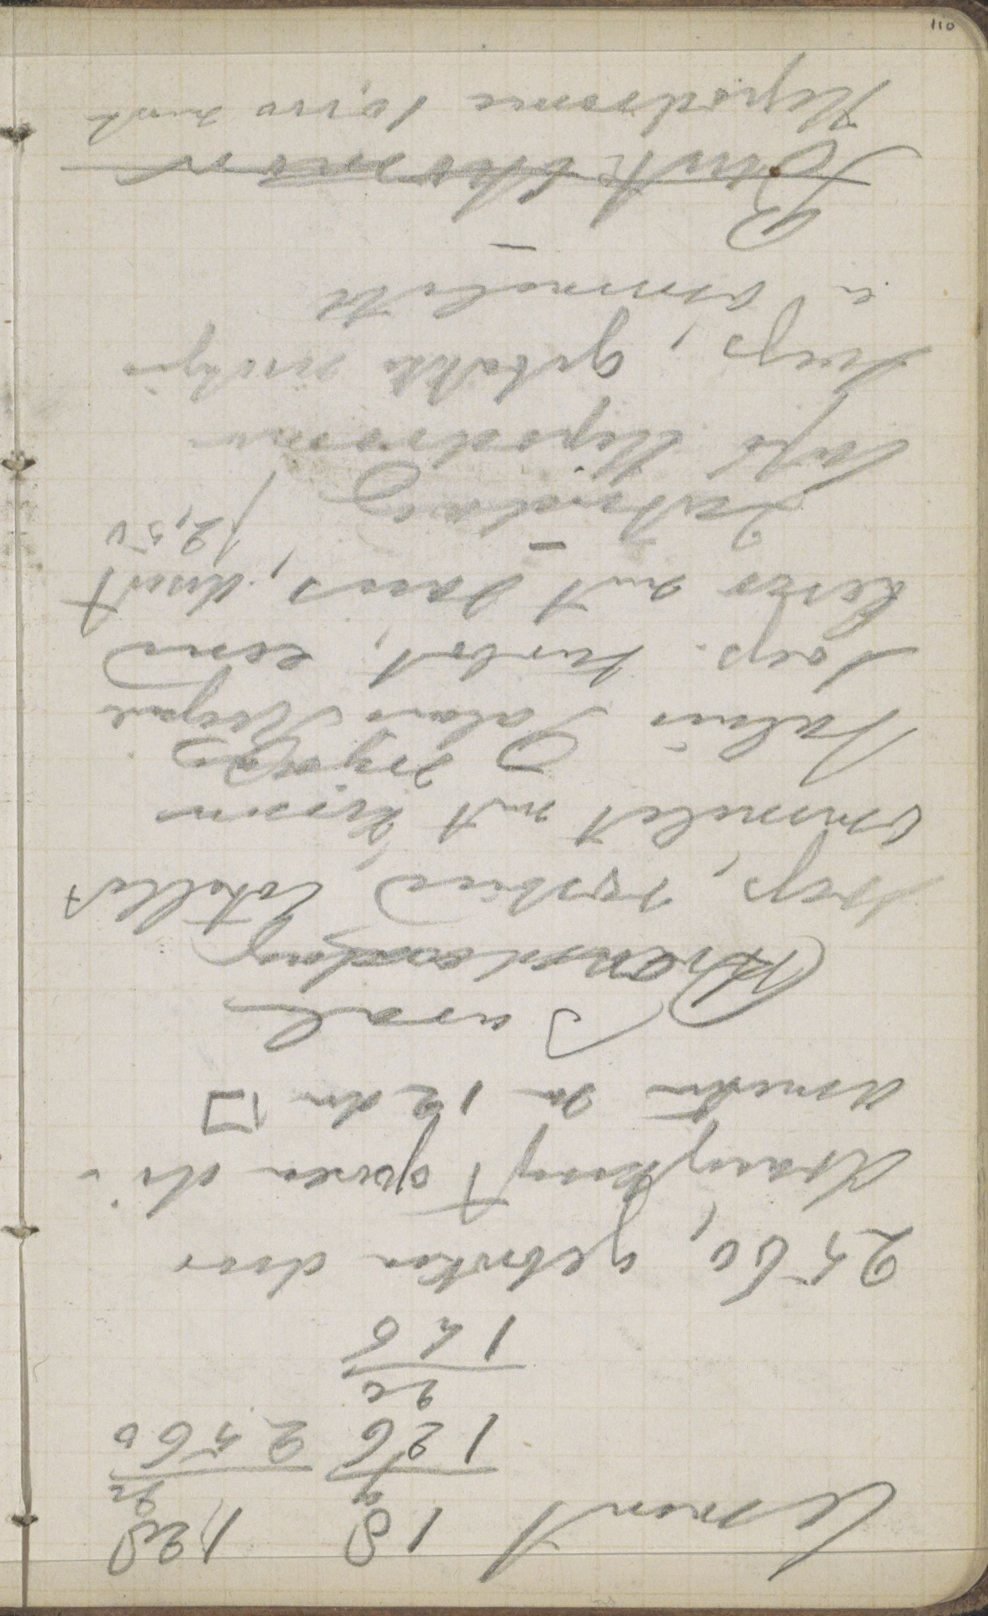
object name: sketchbook leaf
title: Blad met notities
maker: marius bauer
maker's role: draughtsman, print maker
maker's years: 1867-1932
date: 1879-1885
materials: pencil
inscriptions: annotation: ‘[...]’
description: Pagina 110 uit een schetsboek met 58 bladen.